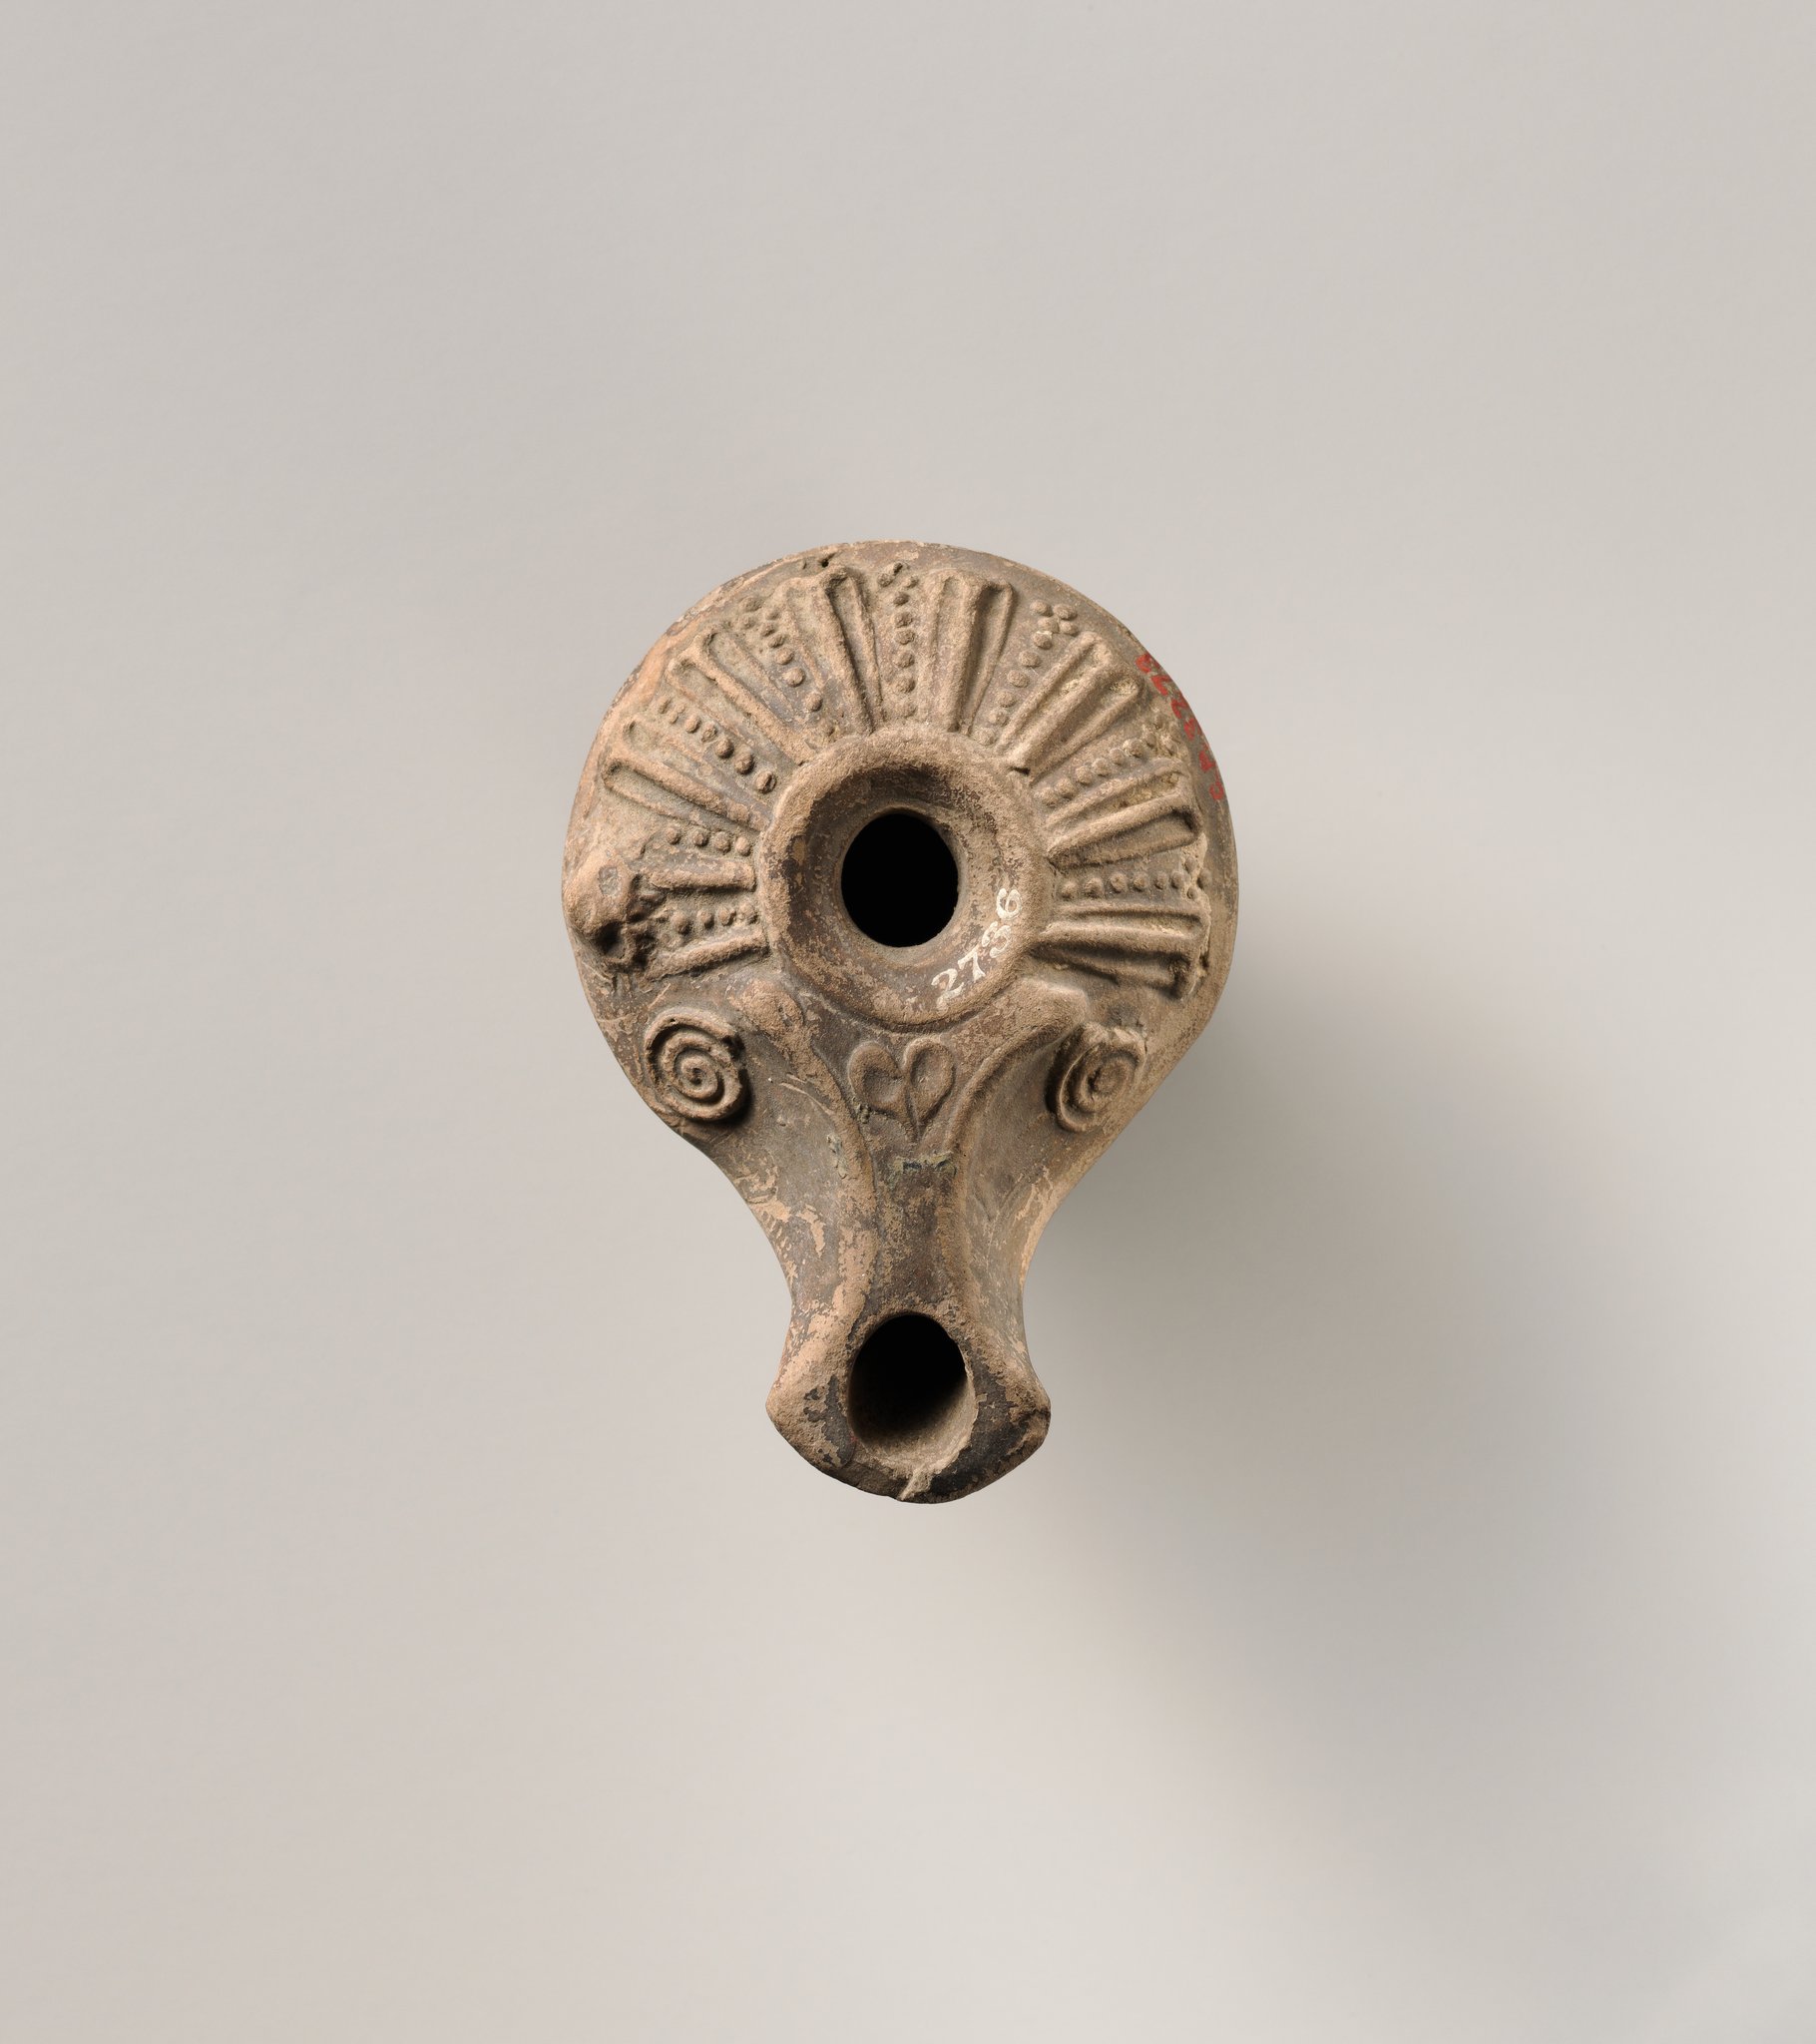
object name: lamp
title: Terracotta oil lamp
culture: greek or roman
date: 100 BCE-100 CE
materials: terracotta